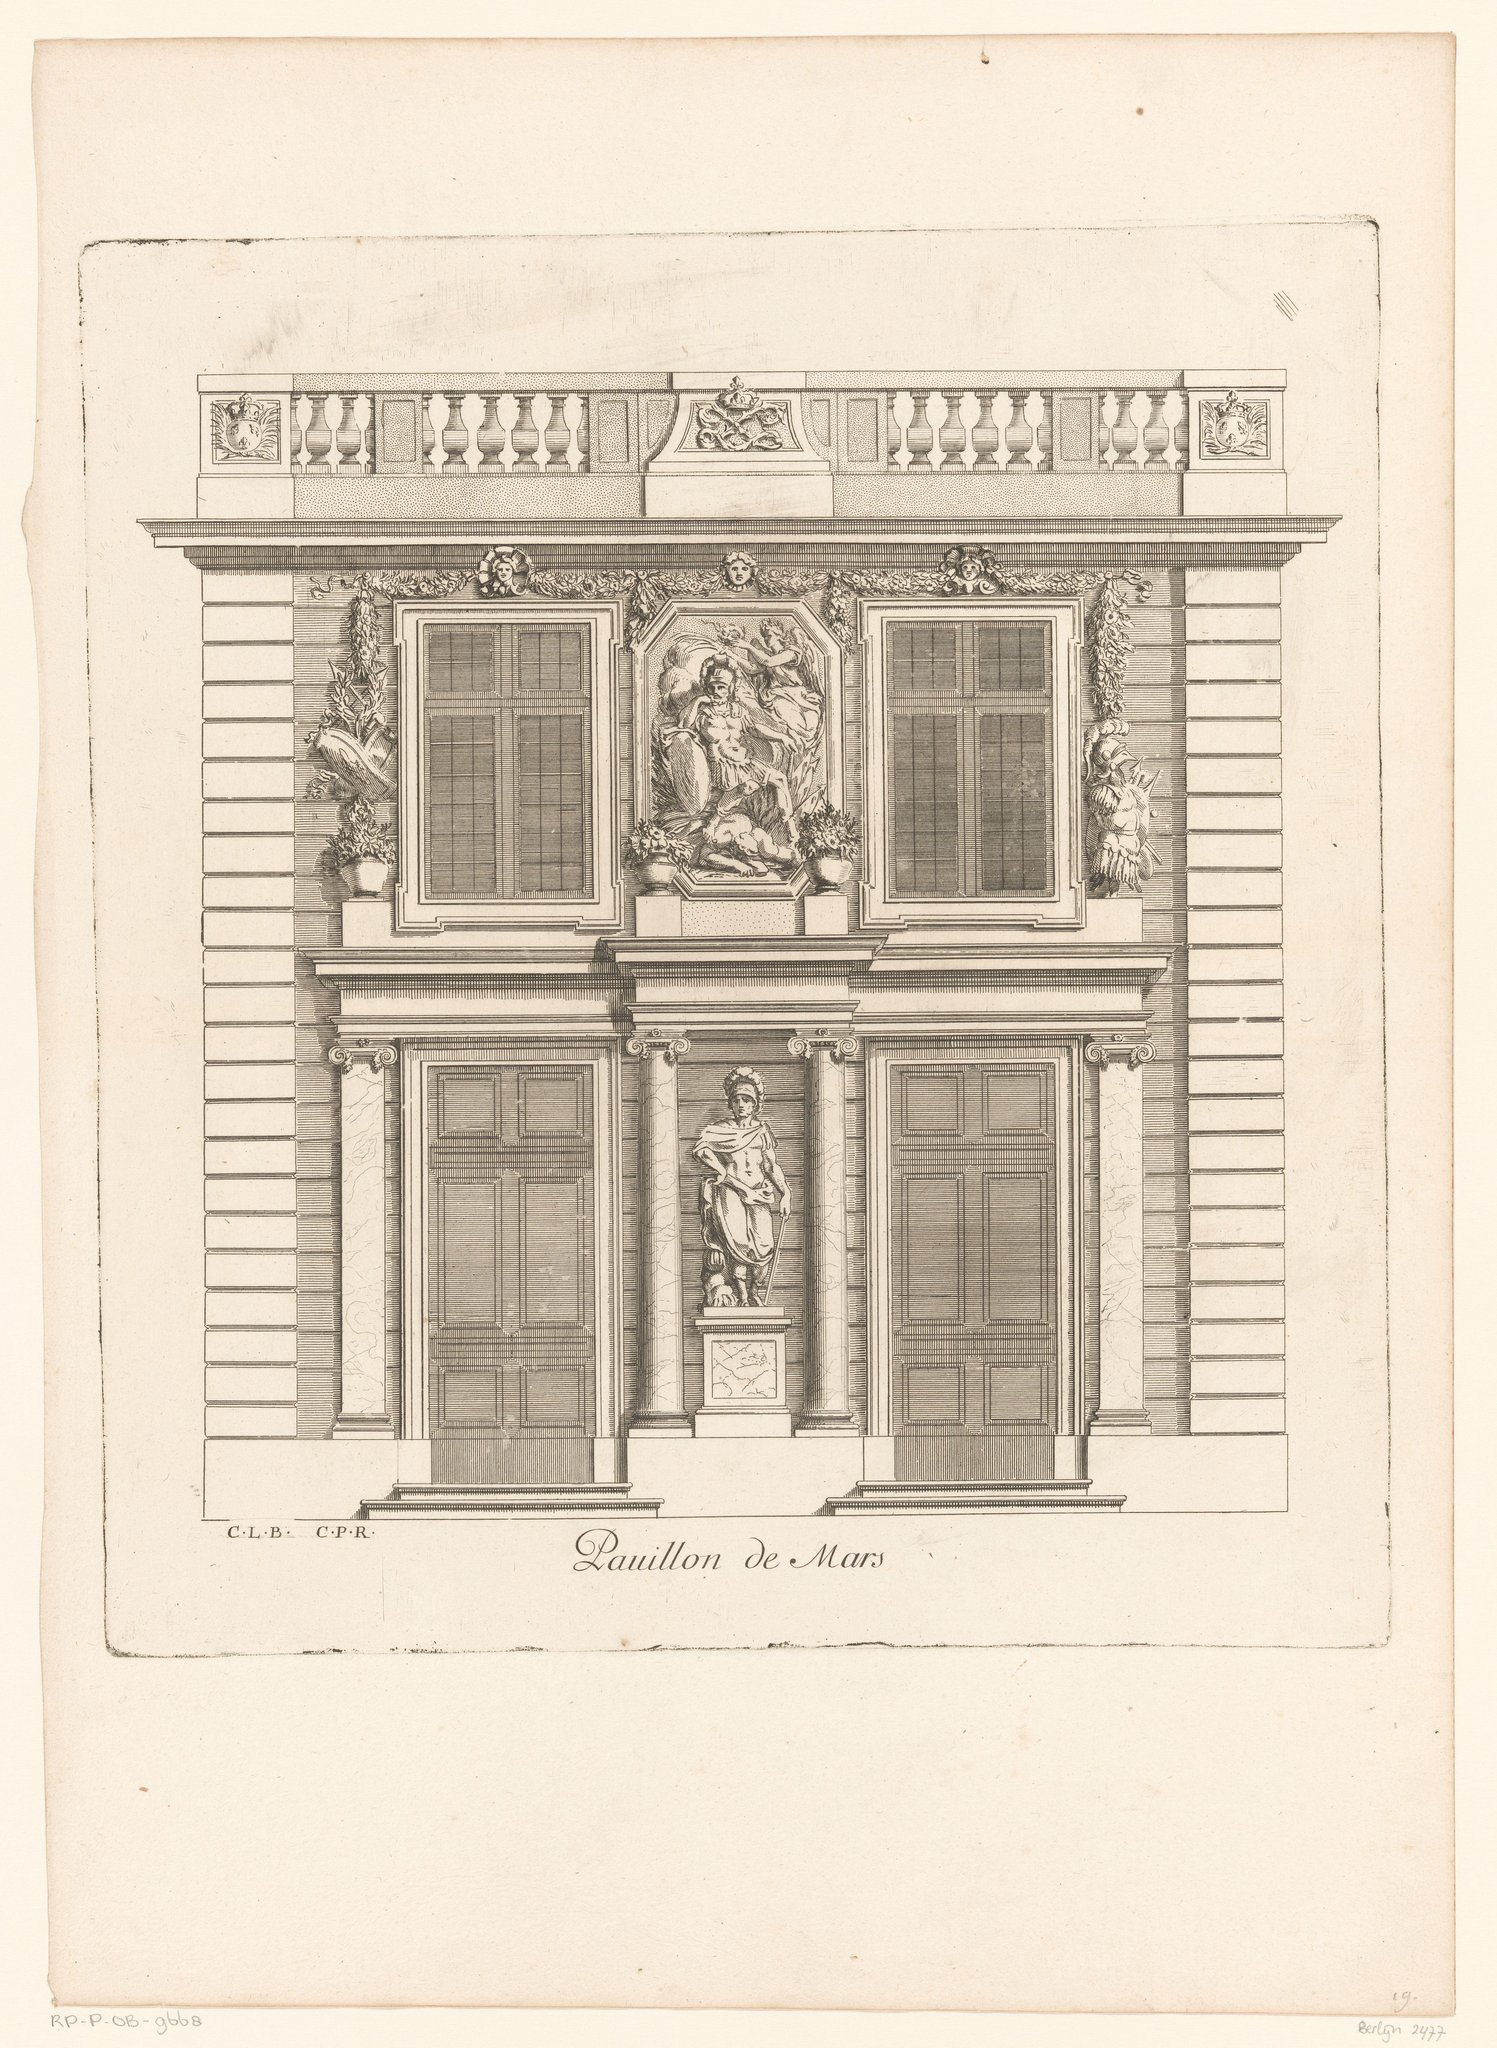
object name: print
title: Divers desseins de Decorations de Pavillons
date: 1672-1686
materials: paper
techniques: etching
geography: paris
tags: (story of) mars (ares), façade (of house or building)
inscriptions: collector's mark: Lugt 2228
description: Façade van een paviljoen met ionische zuilen en pilasters, wapentrofeeën, een paneel met de triomf van Mars, een beeld van Mars en een balustrade aan de bovenzijde.